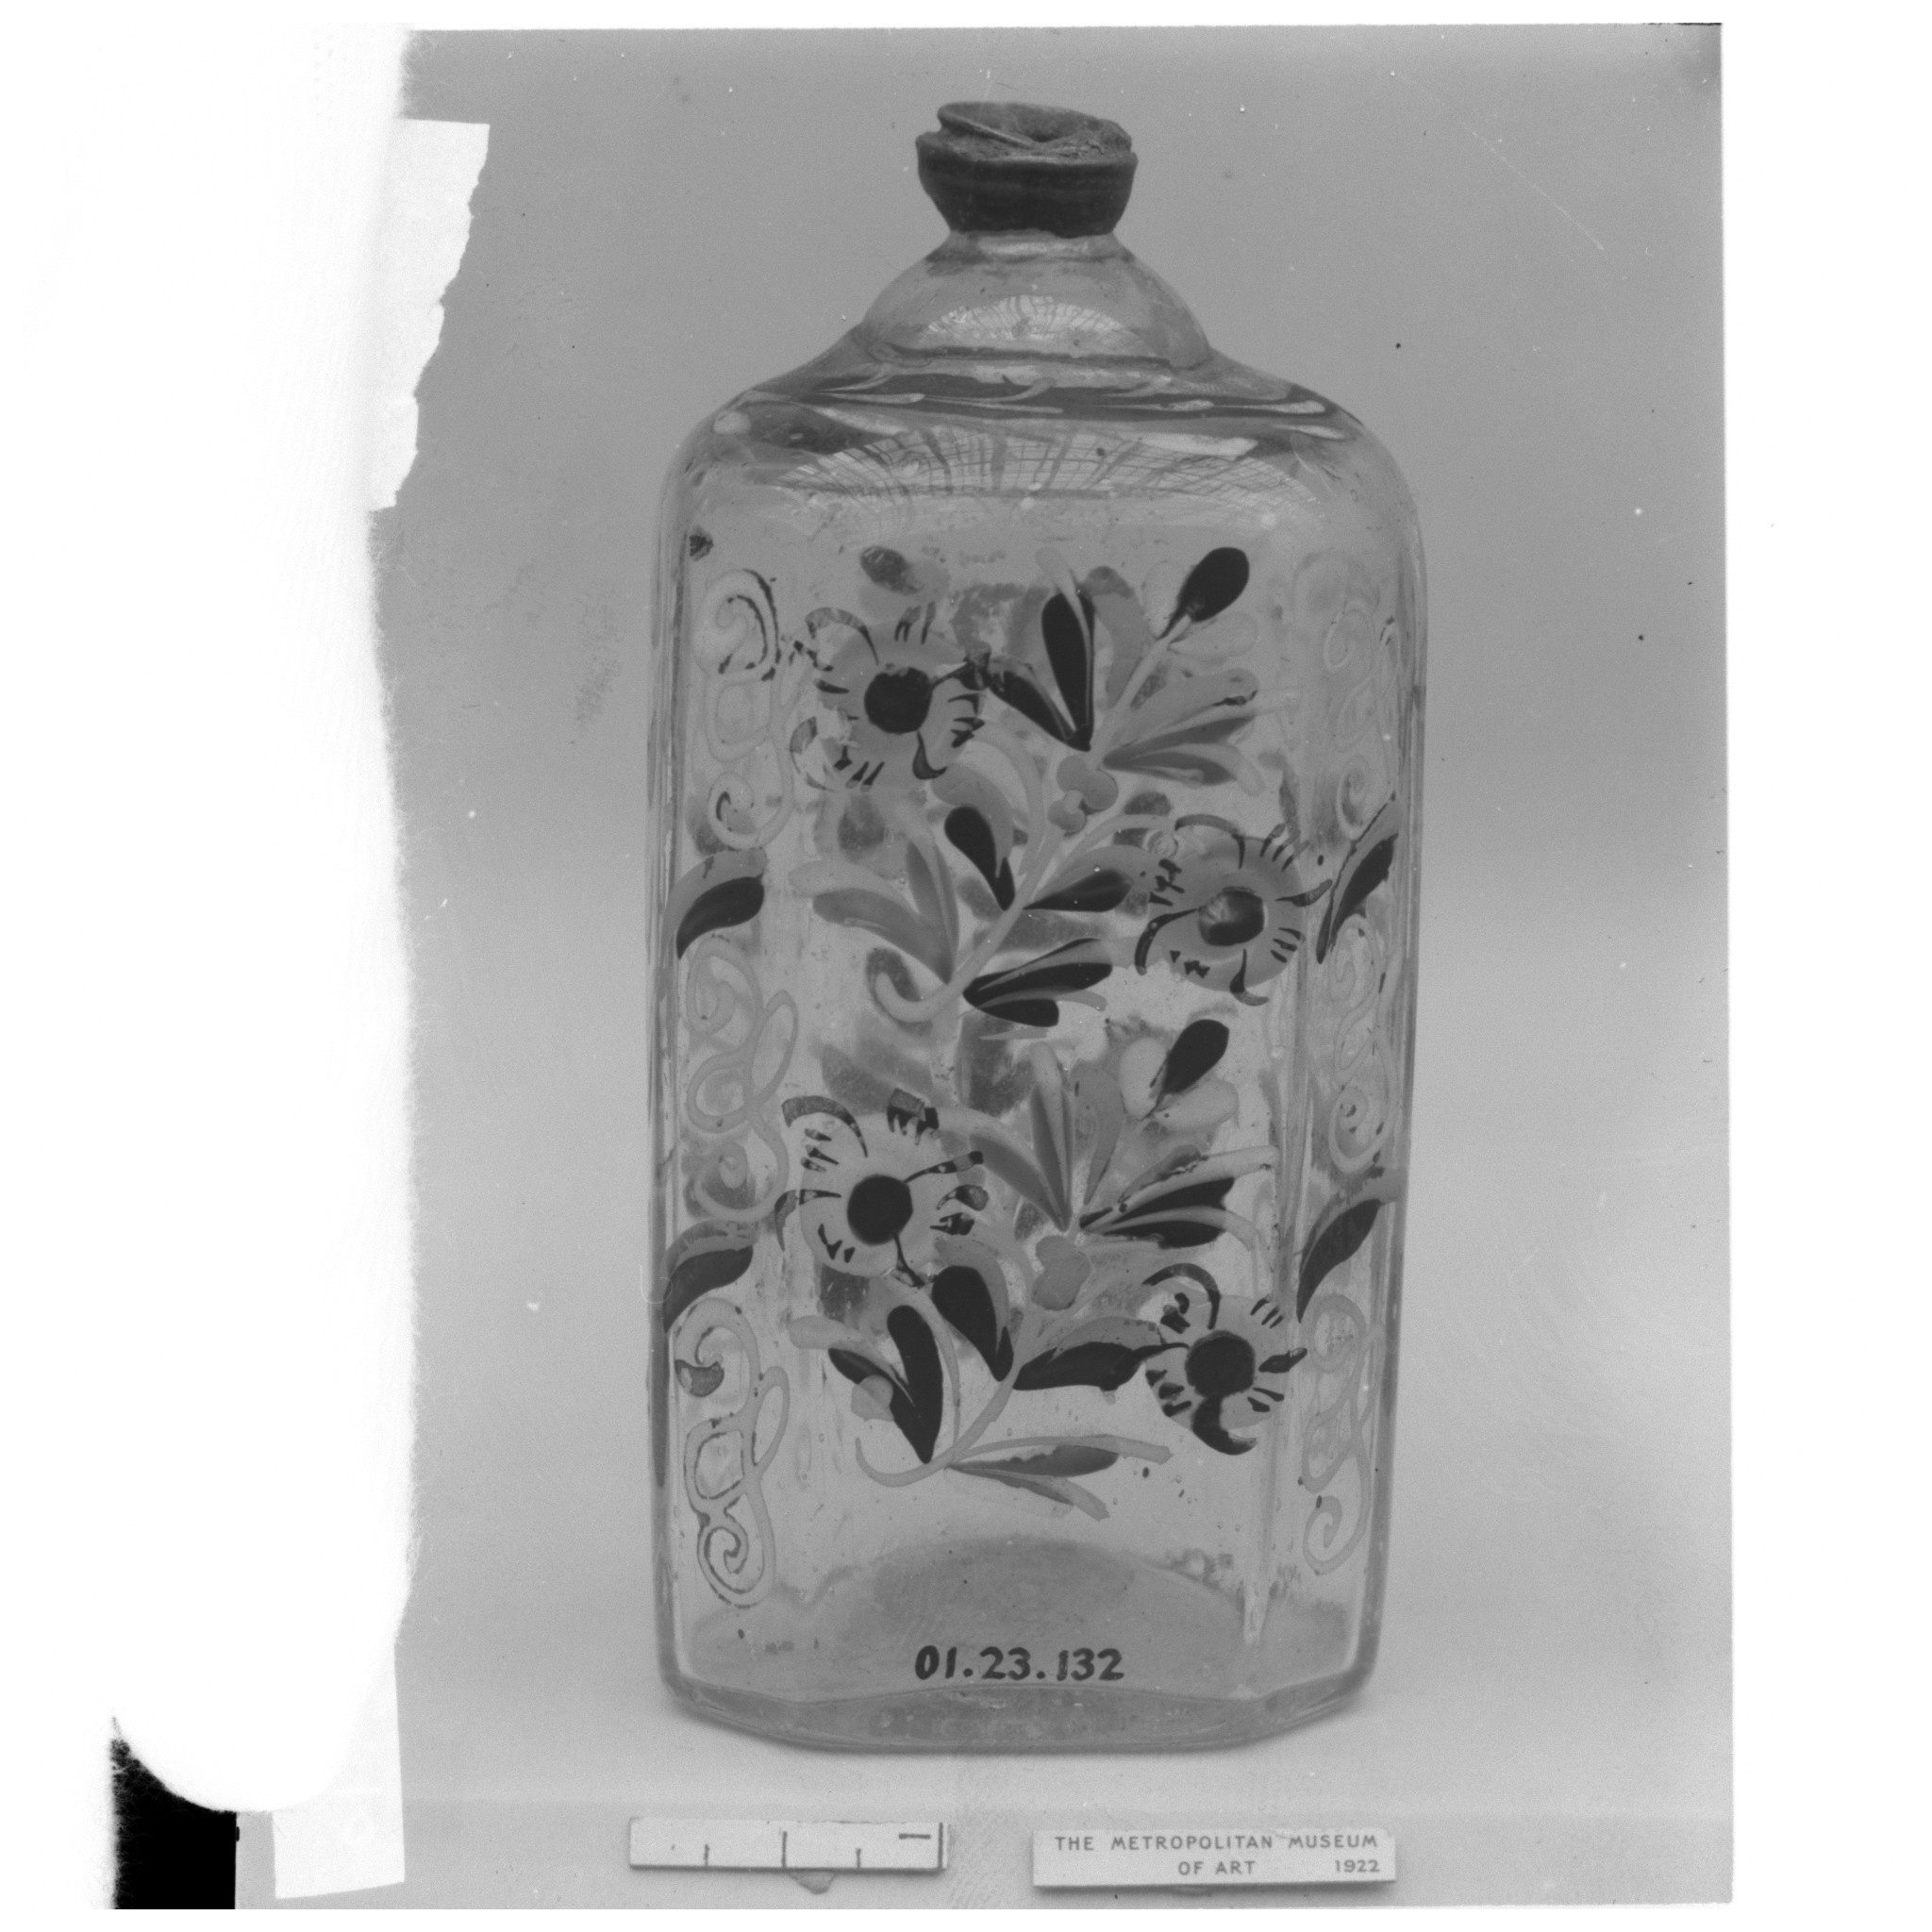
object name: bottle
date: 1701-1800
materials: glass, pewter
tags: flowers